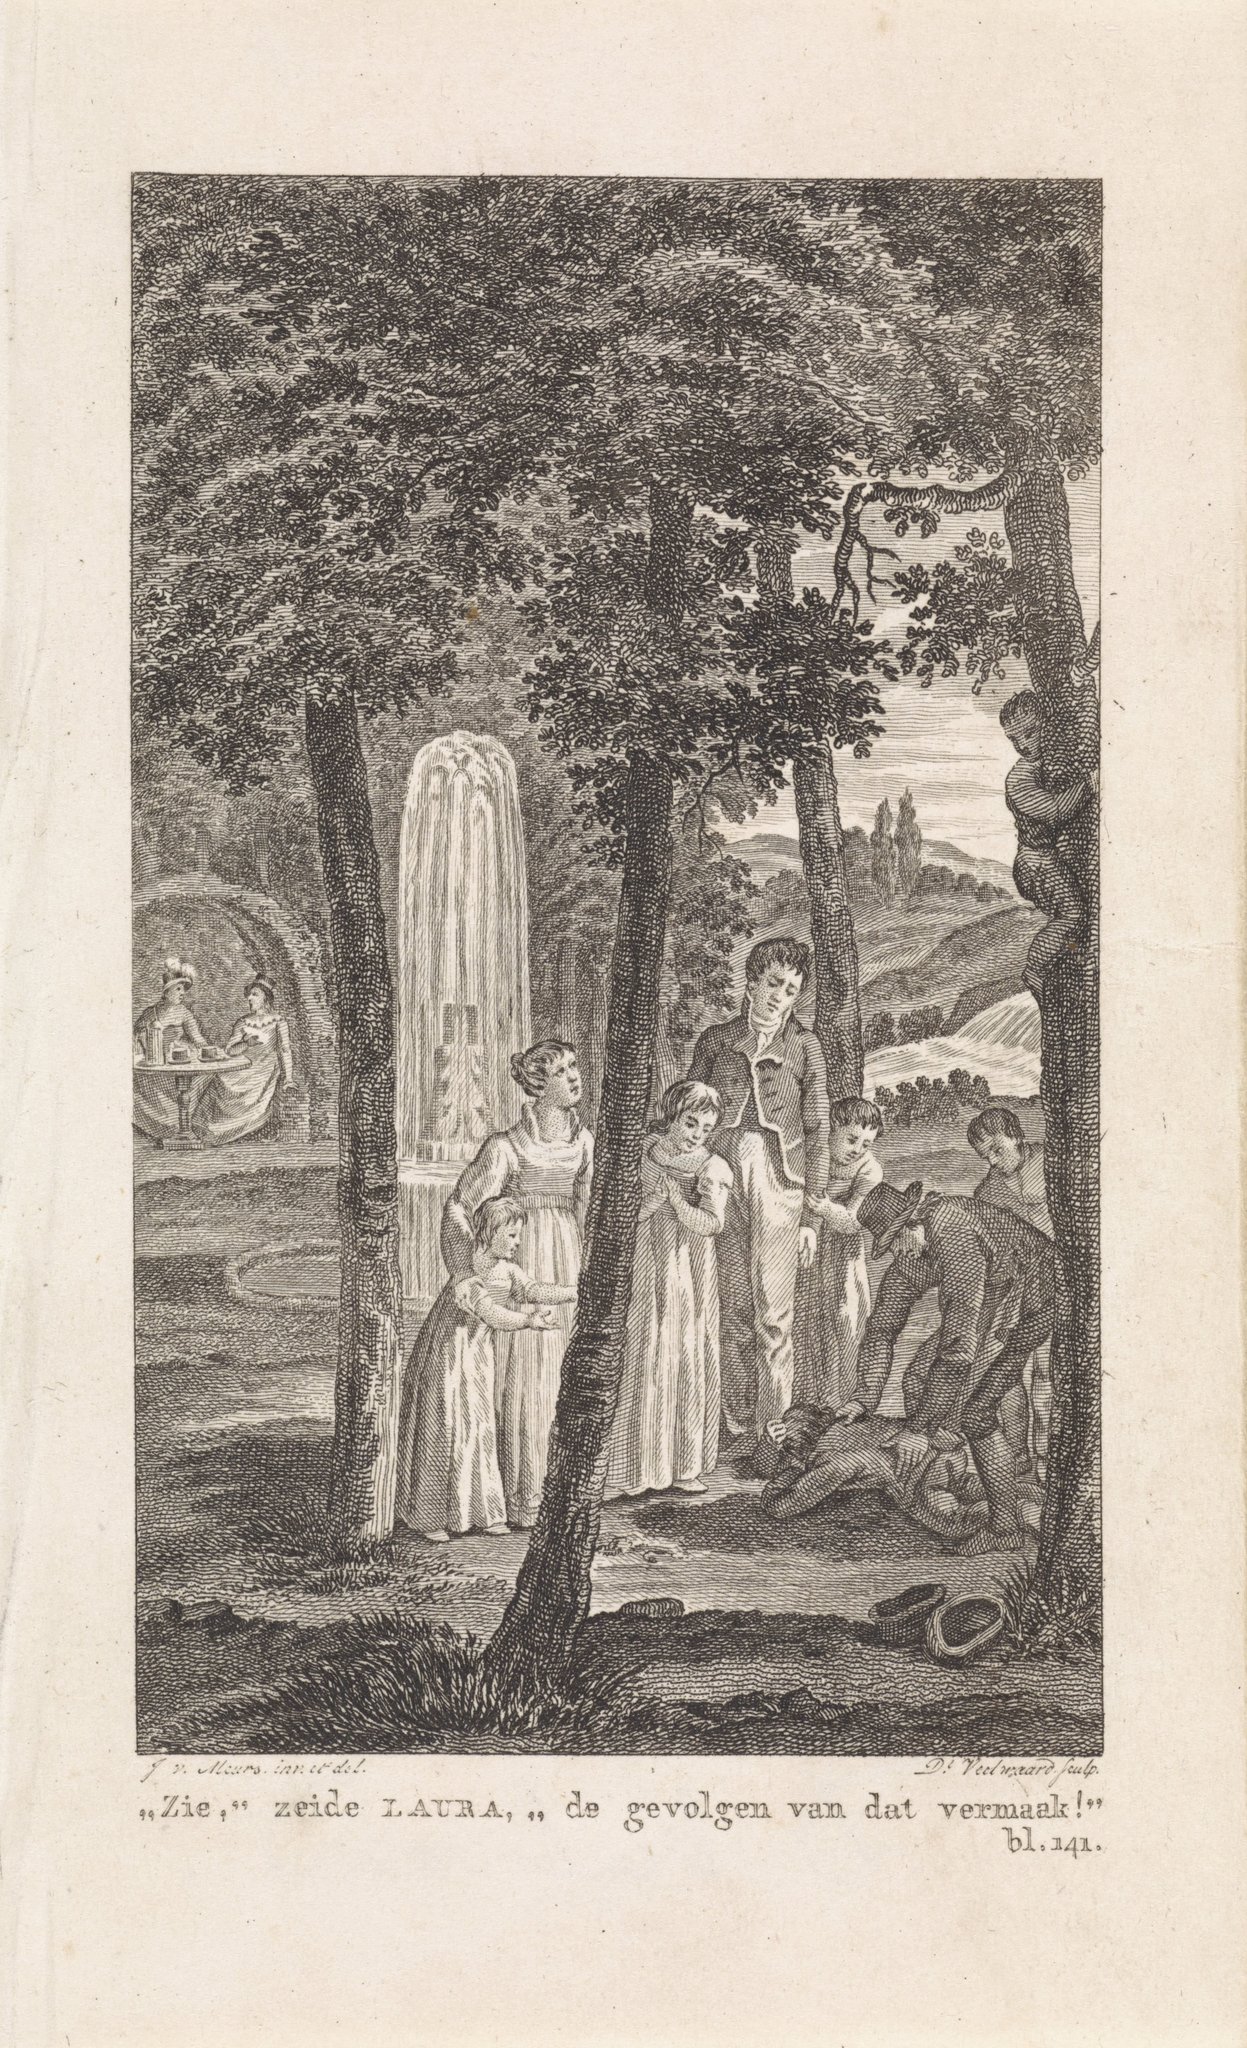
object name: print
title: "Zie," zeide Laura, "de gevolgen van dat vermaak"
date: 1823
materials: paper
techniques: etching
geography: amsterdam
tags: lying face downwards, garden fountain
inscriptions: collector's mark: Lugt 2228, collector's mark: Lugt 2760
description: Prent gebruikt als boekillustratie in: Hazeu Cornelisz., Johannes. De geschiedenis van Laura Guldenbeek: Een onderhoudend en leerzaam leesboek voor jonge lieden. Amsterdam: M.H. Helmig, 1823.